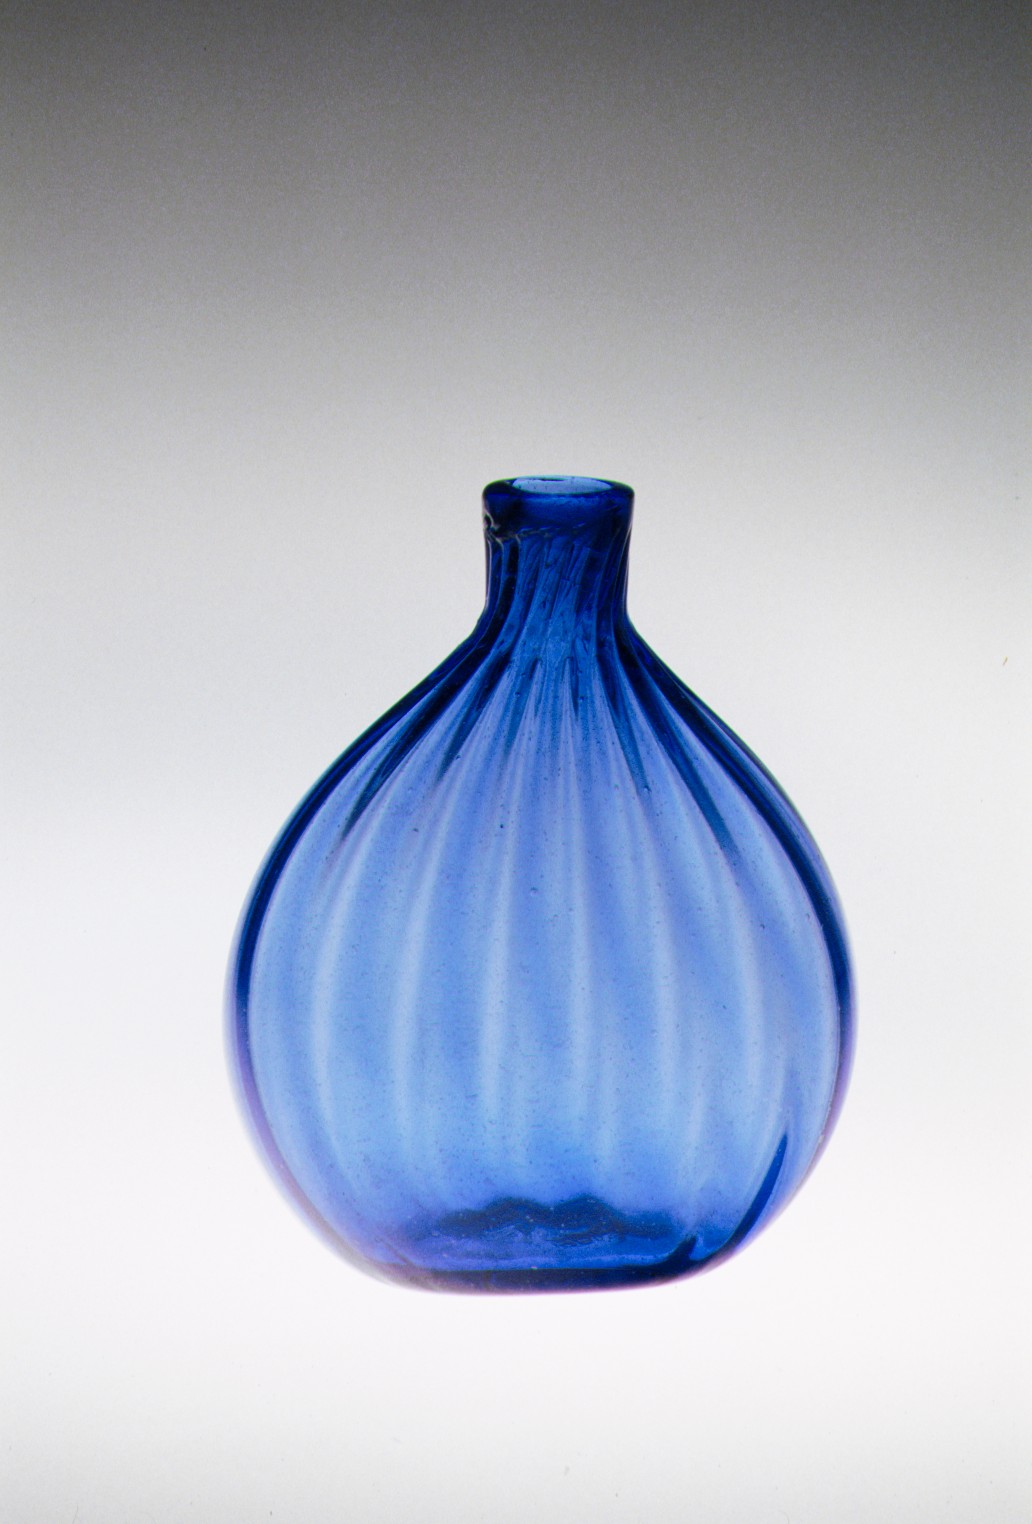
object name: pocket flask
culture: american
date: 1800-1860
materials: glass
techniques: glassblowing, molding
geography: united states